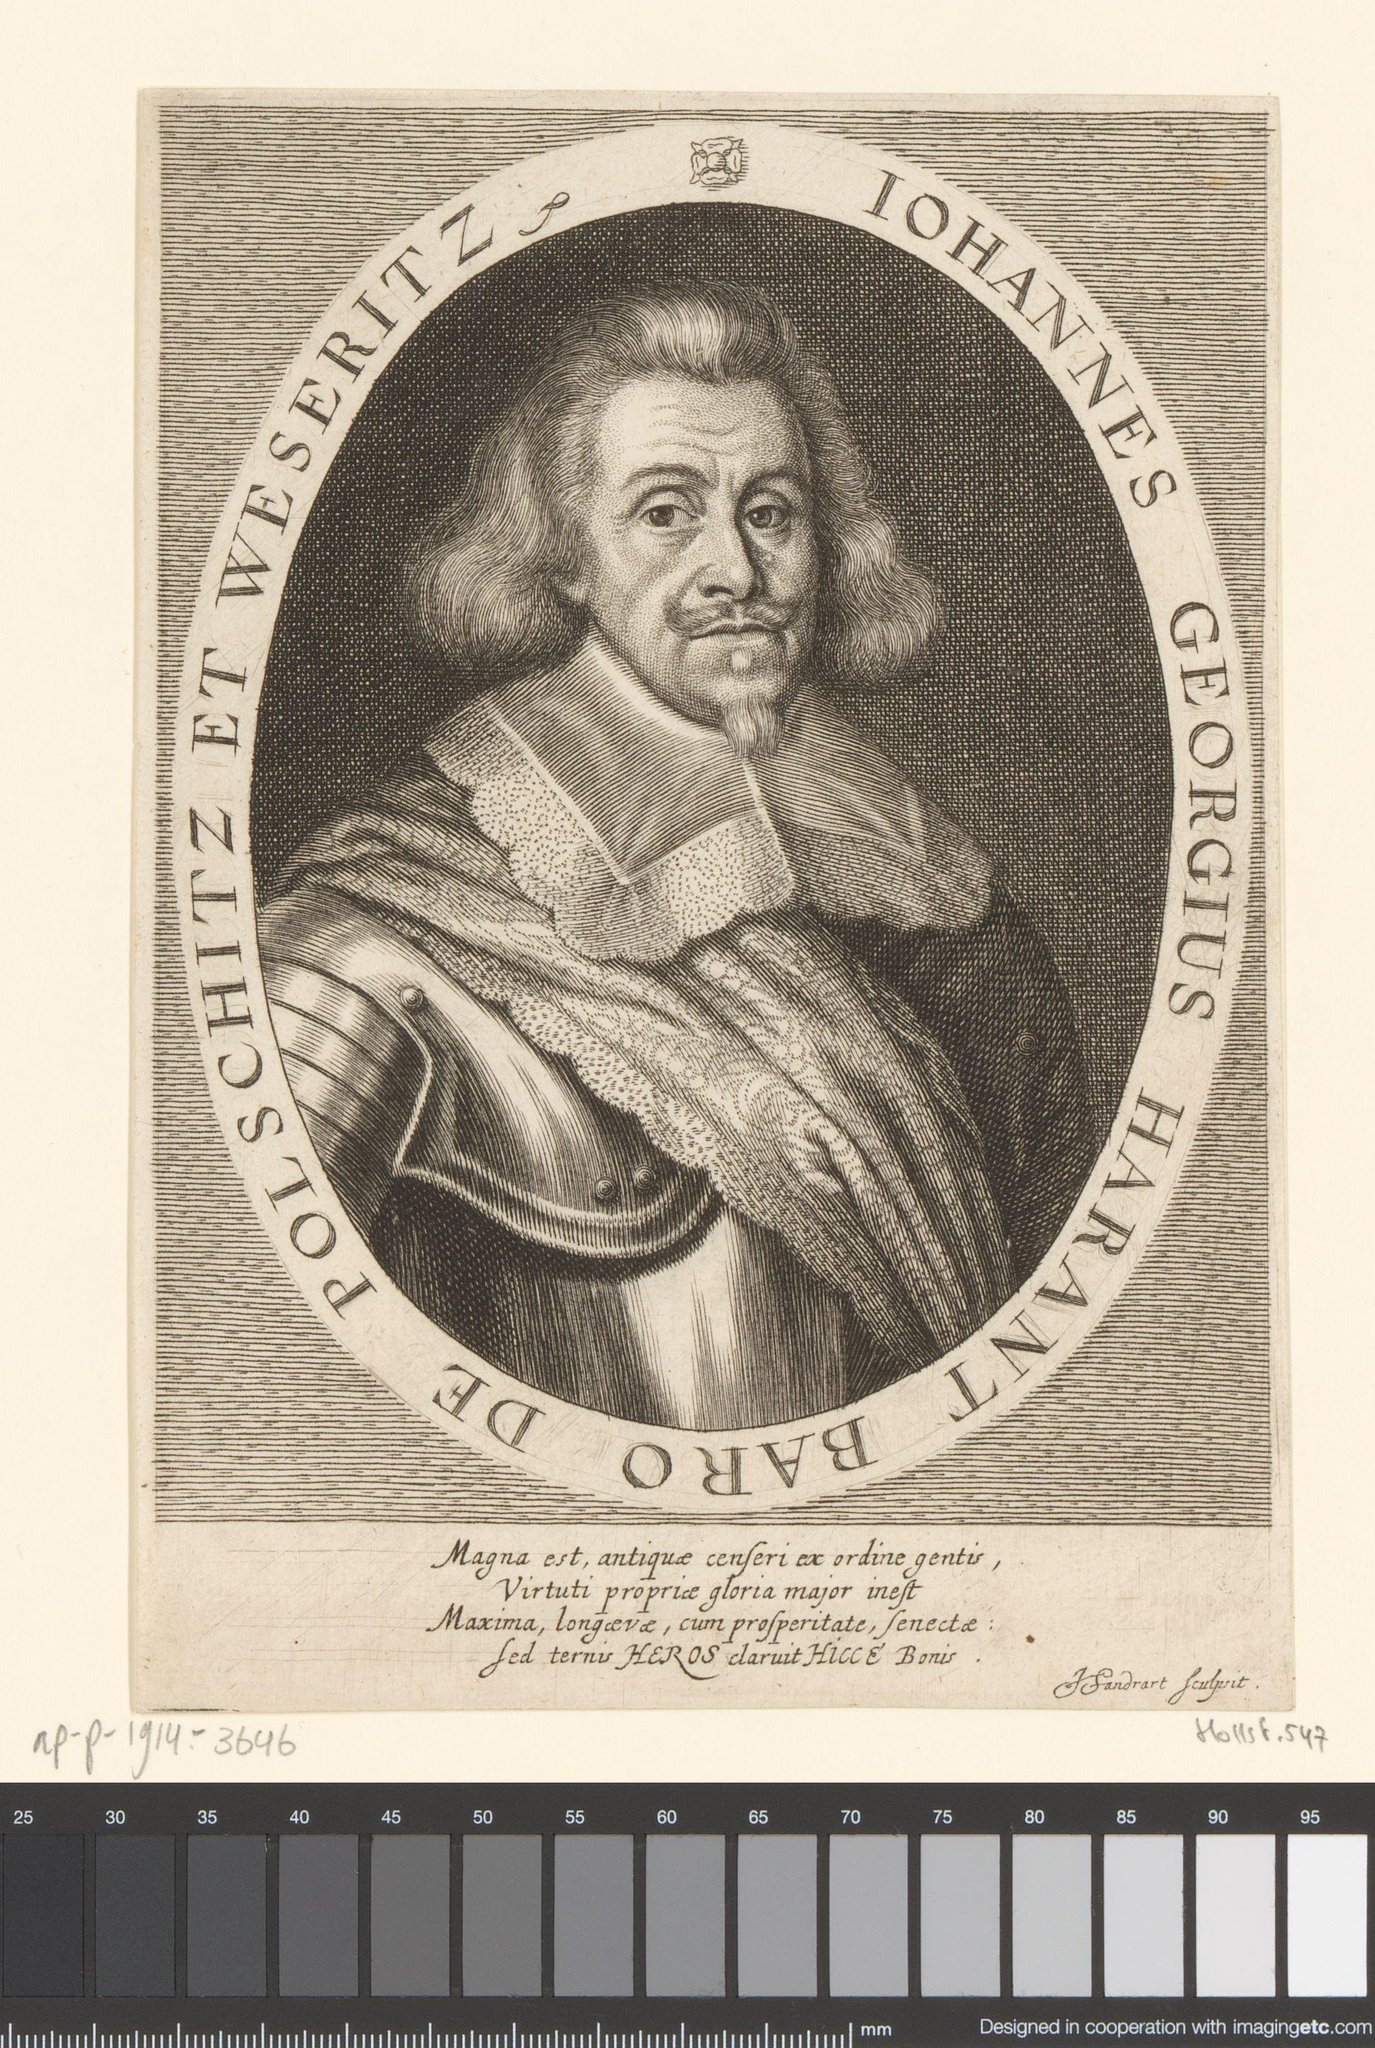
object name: print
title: Portret van Johann Georg Harant, Freiherr von Polschitz und Weseritz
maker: jakob von sandrart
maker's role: print maker, publisher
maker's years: 1630-1708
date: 1640-1708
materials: paper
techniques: engraving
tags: armour, historical persons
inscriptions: collector's mark: Lugt 2228